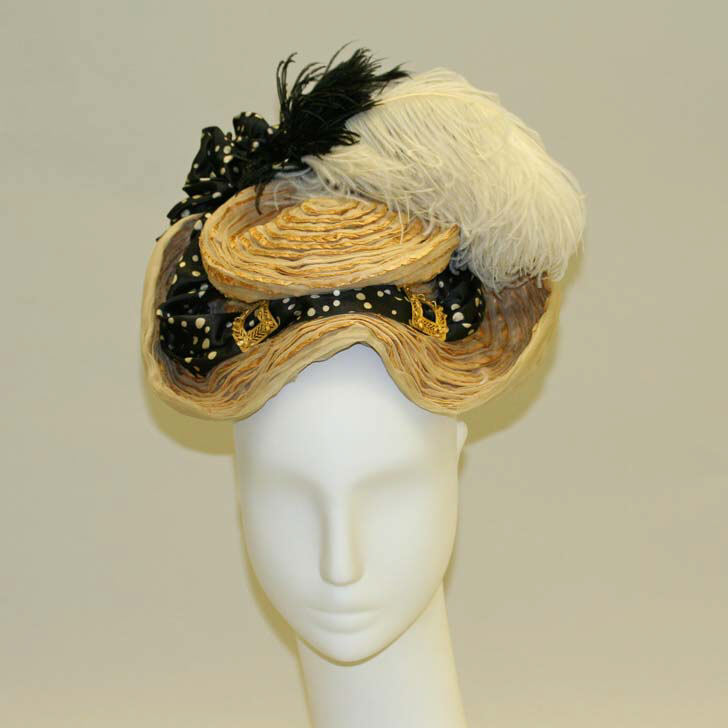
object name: tricorne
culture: american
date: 1901-1902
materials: feather, metal, silk, fiber